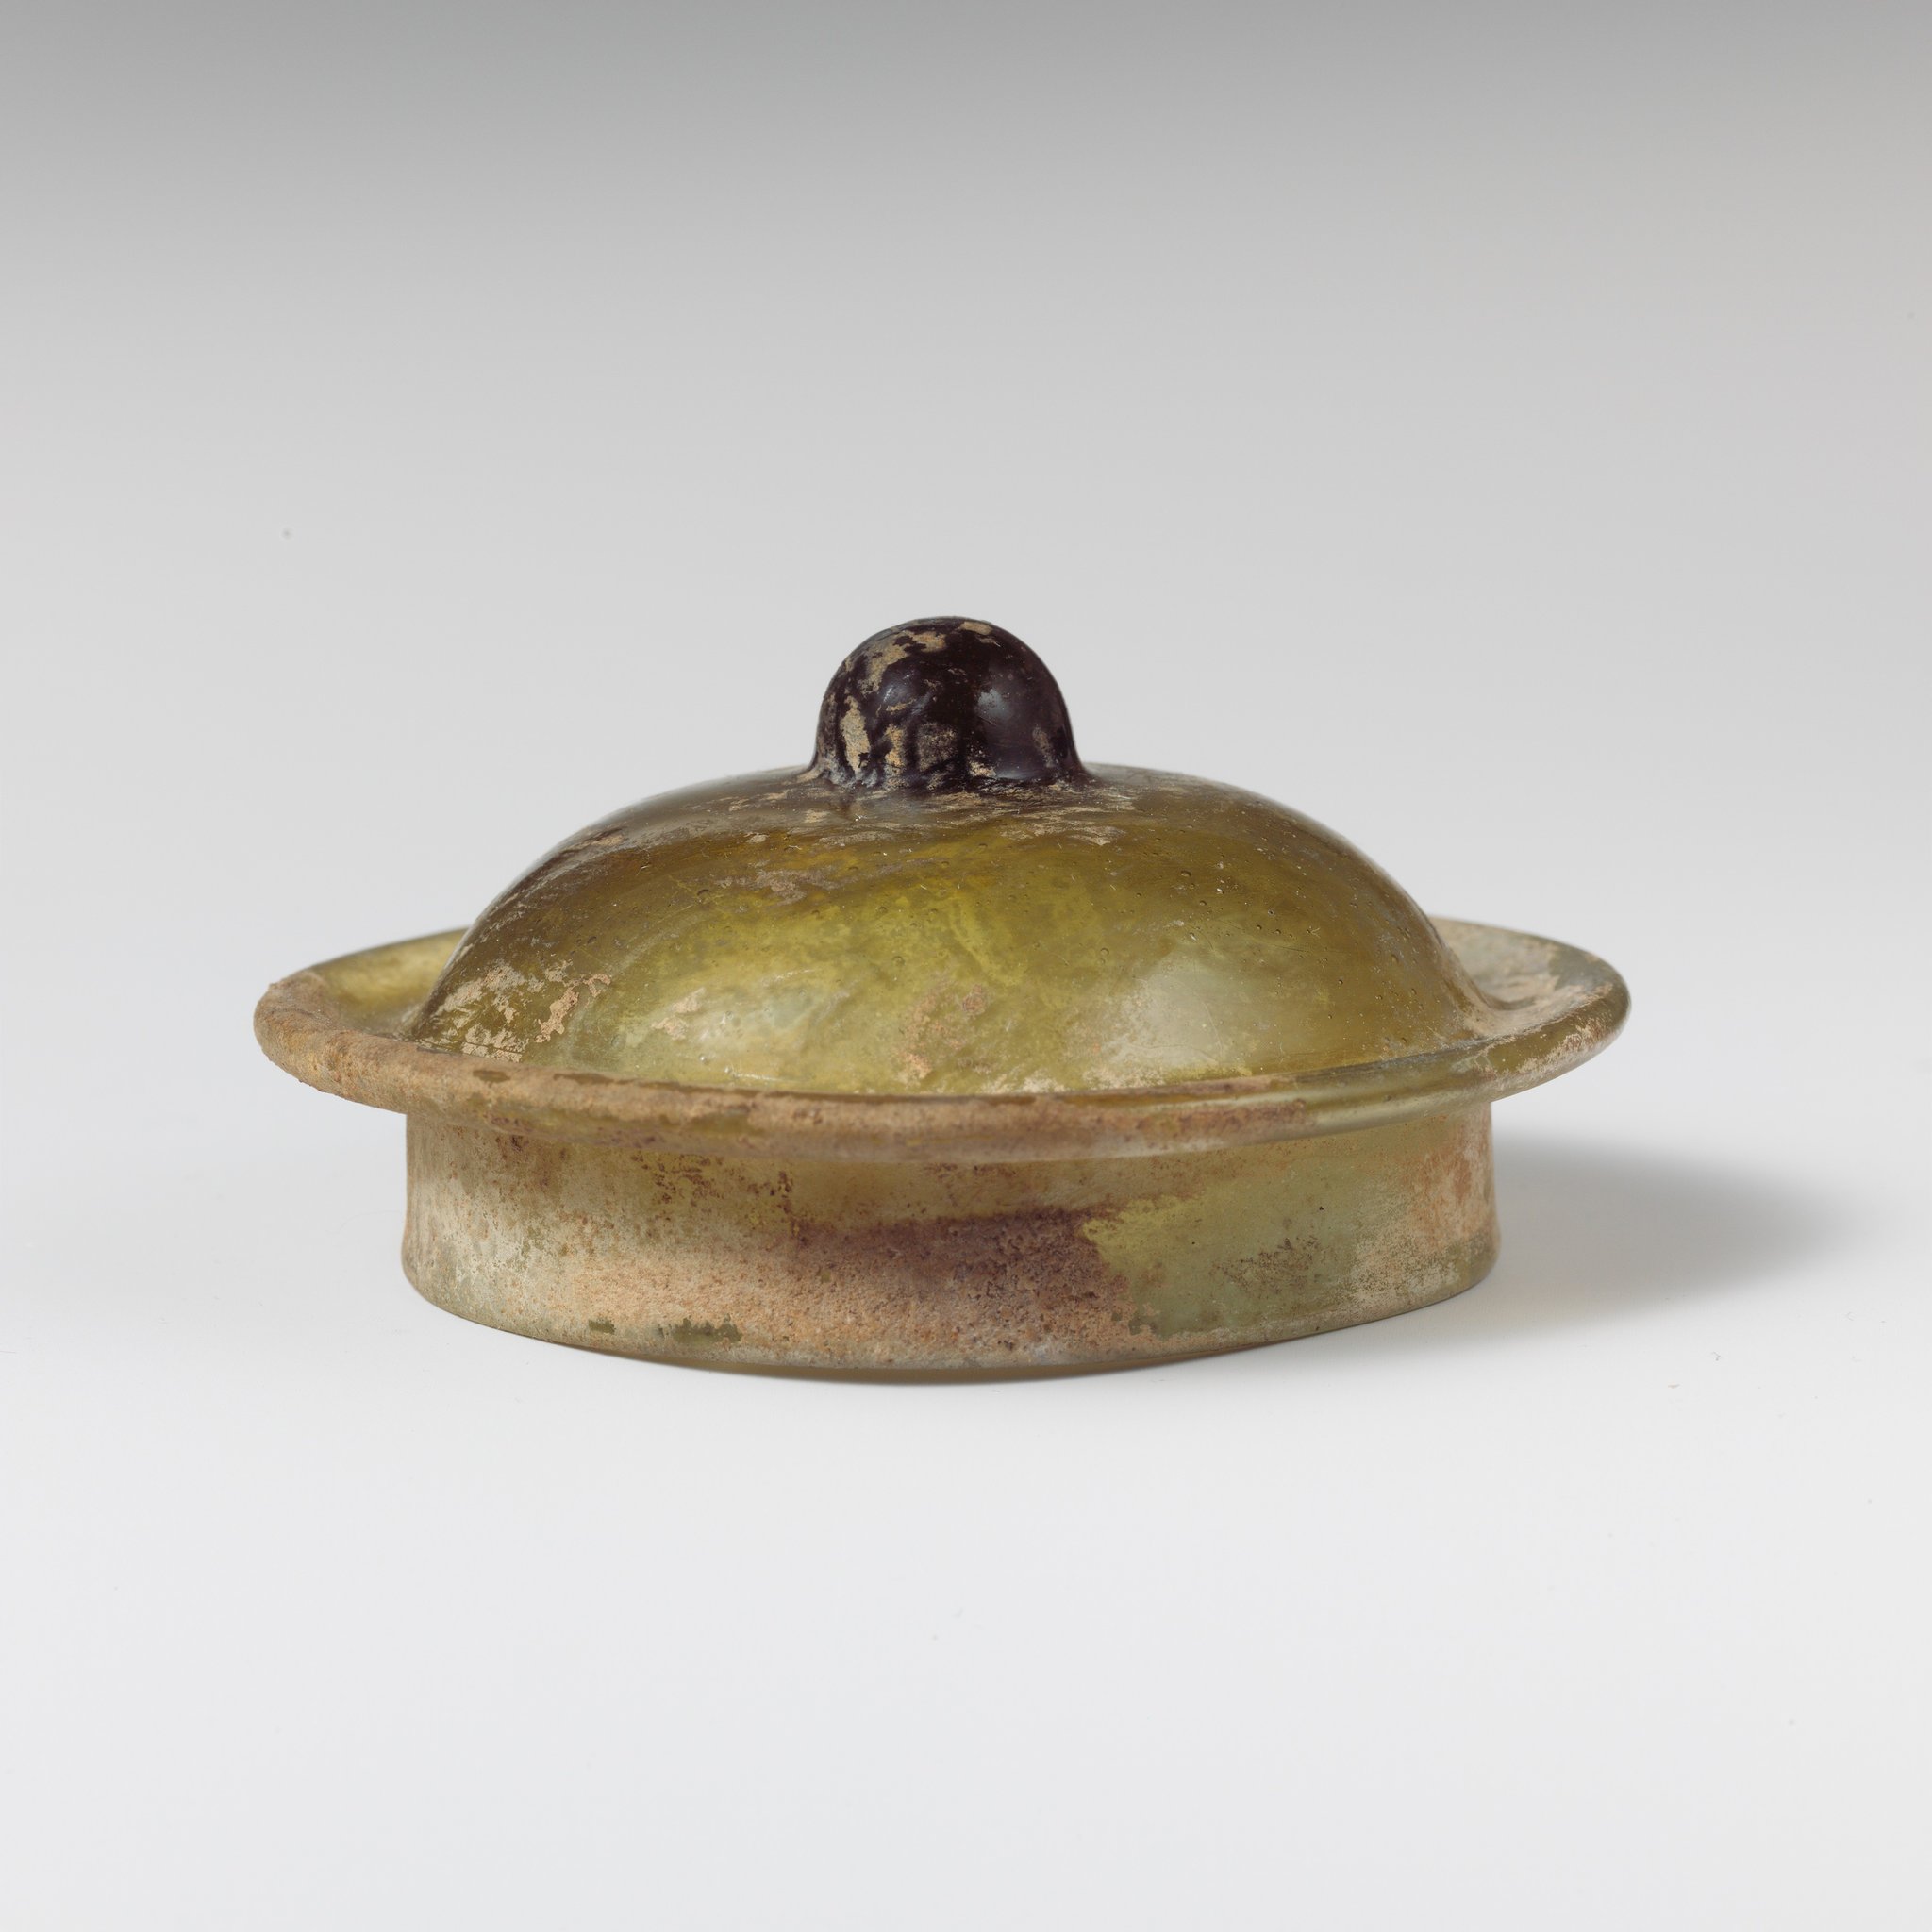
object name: lid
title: Glass lid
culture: roman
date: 101-300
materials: glass